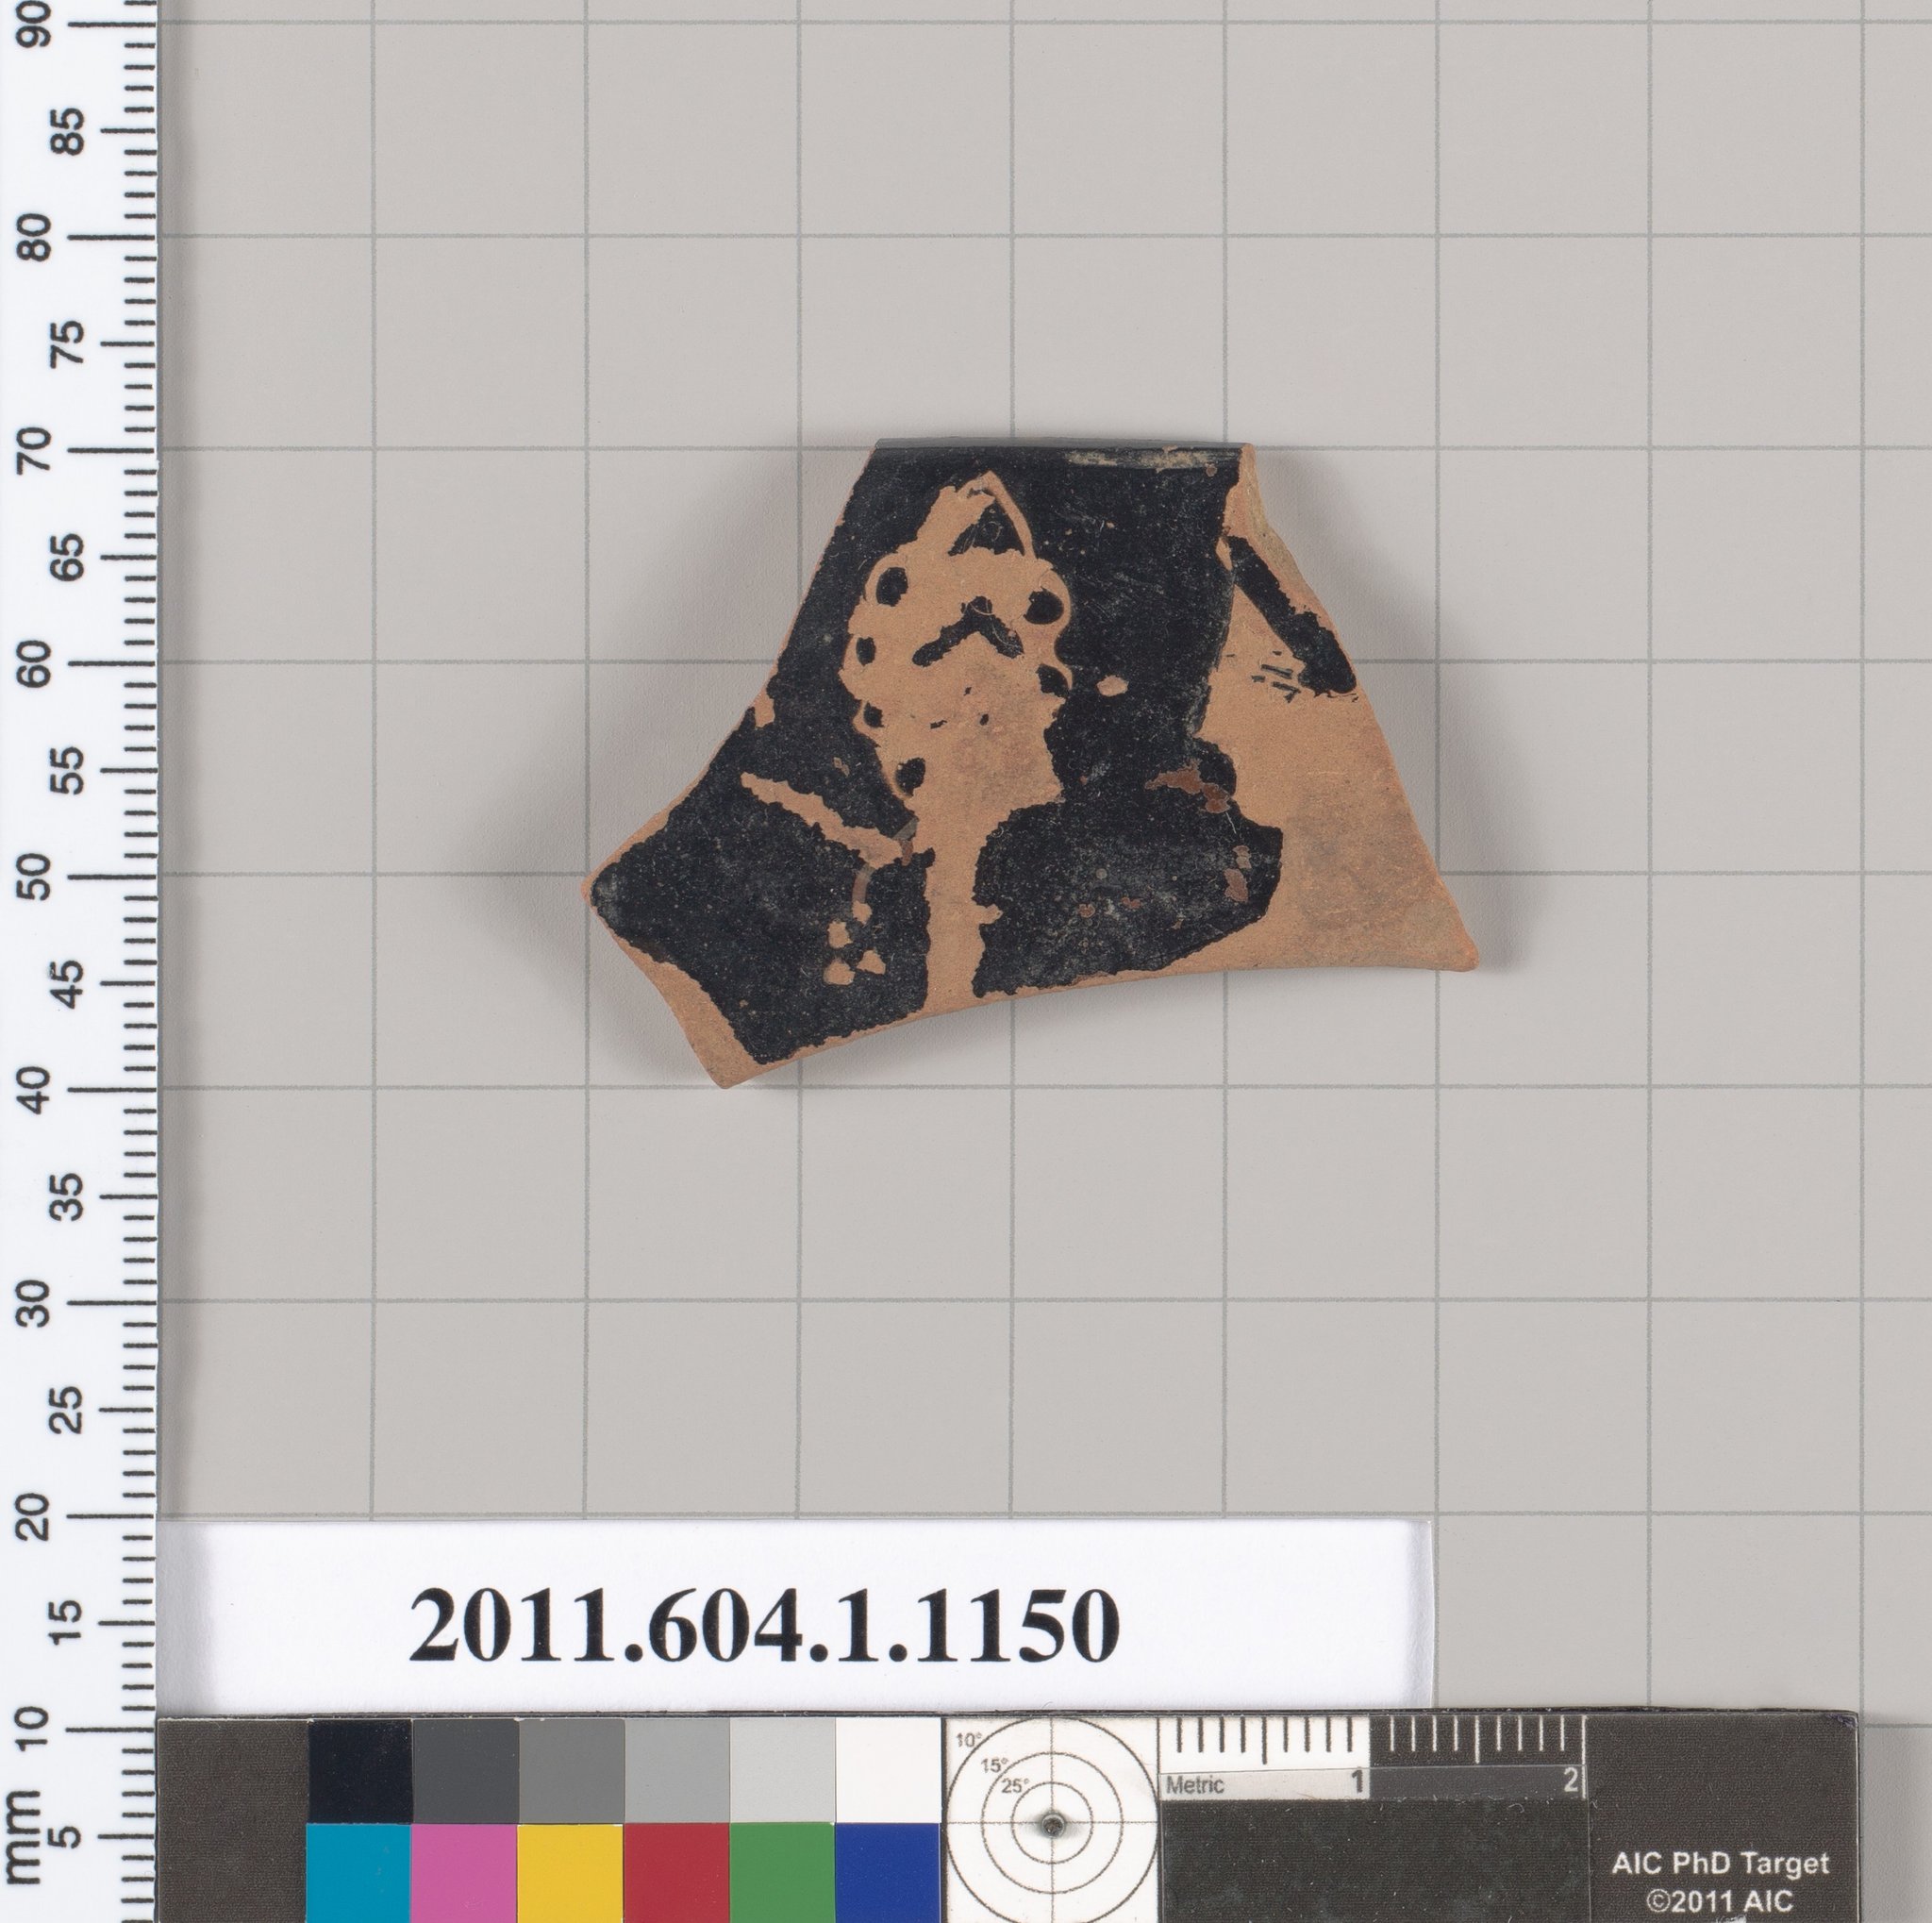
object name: kylix fragment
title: Terracotta rim fragment of a kylix (drinking cup)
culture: greek, attic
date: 467-435 BCE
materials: terracotta